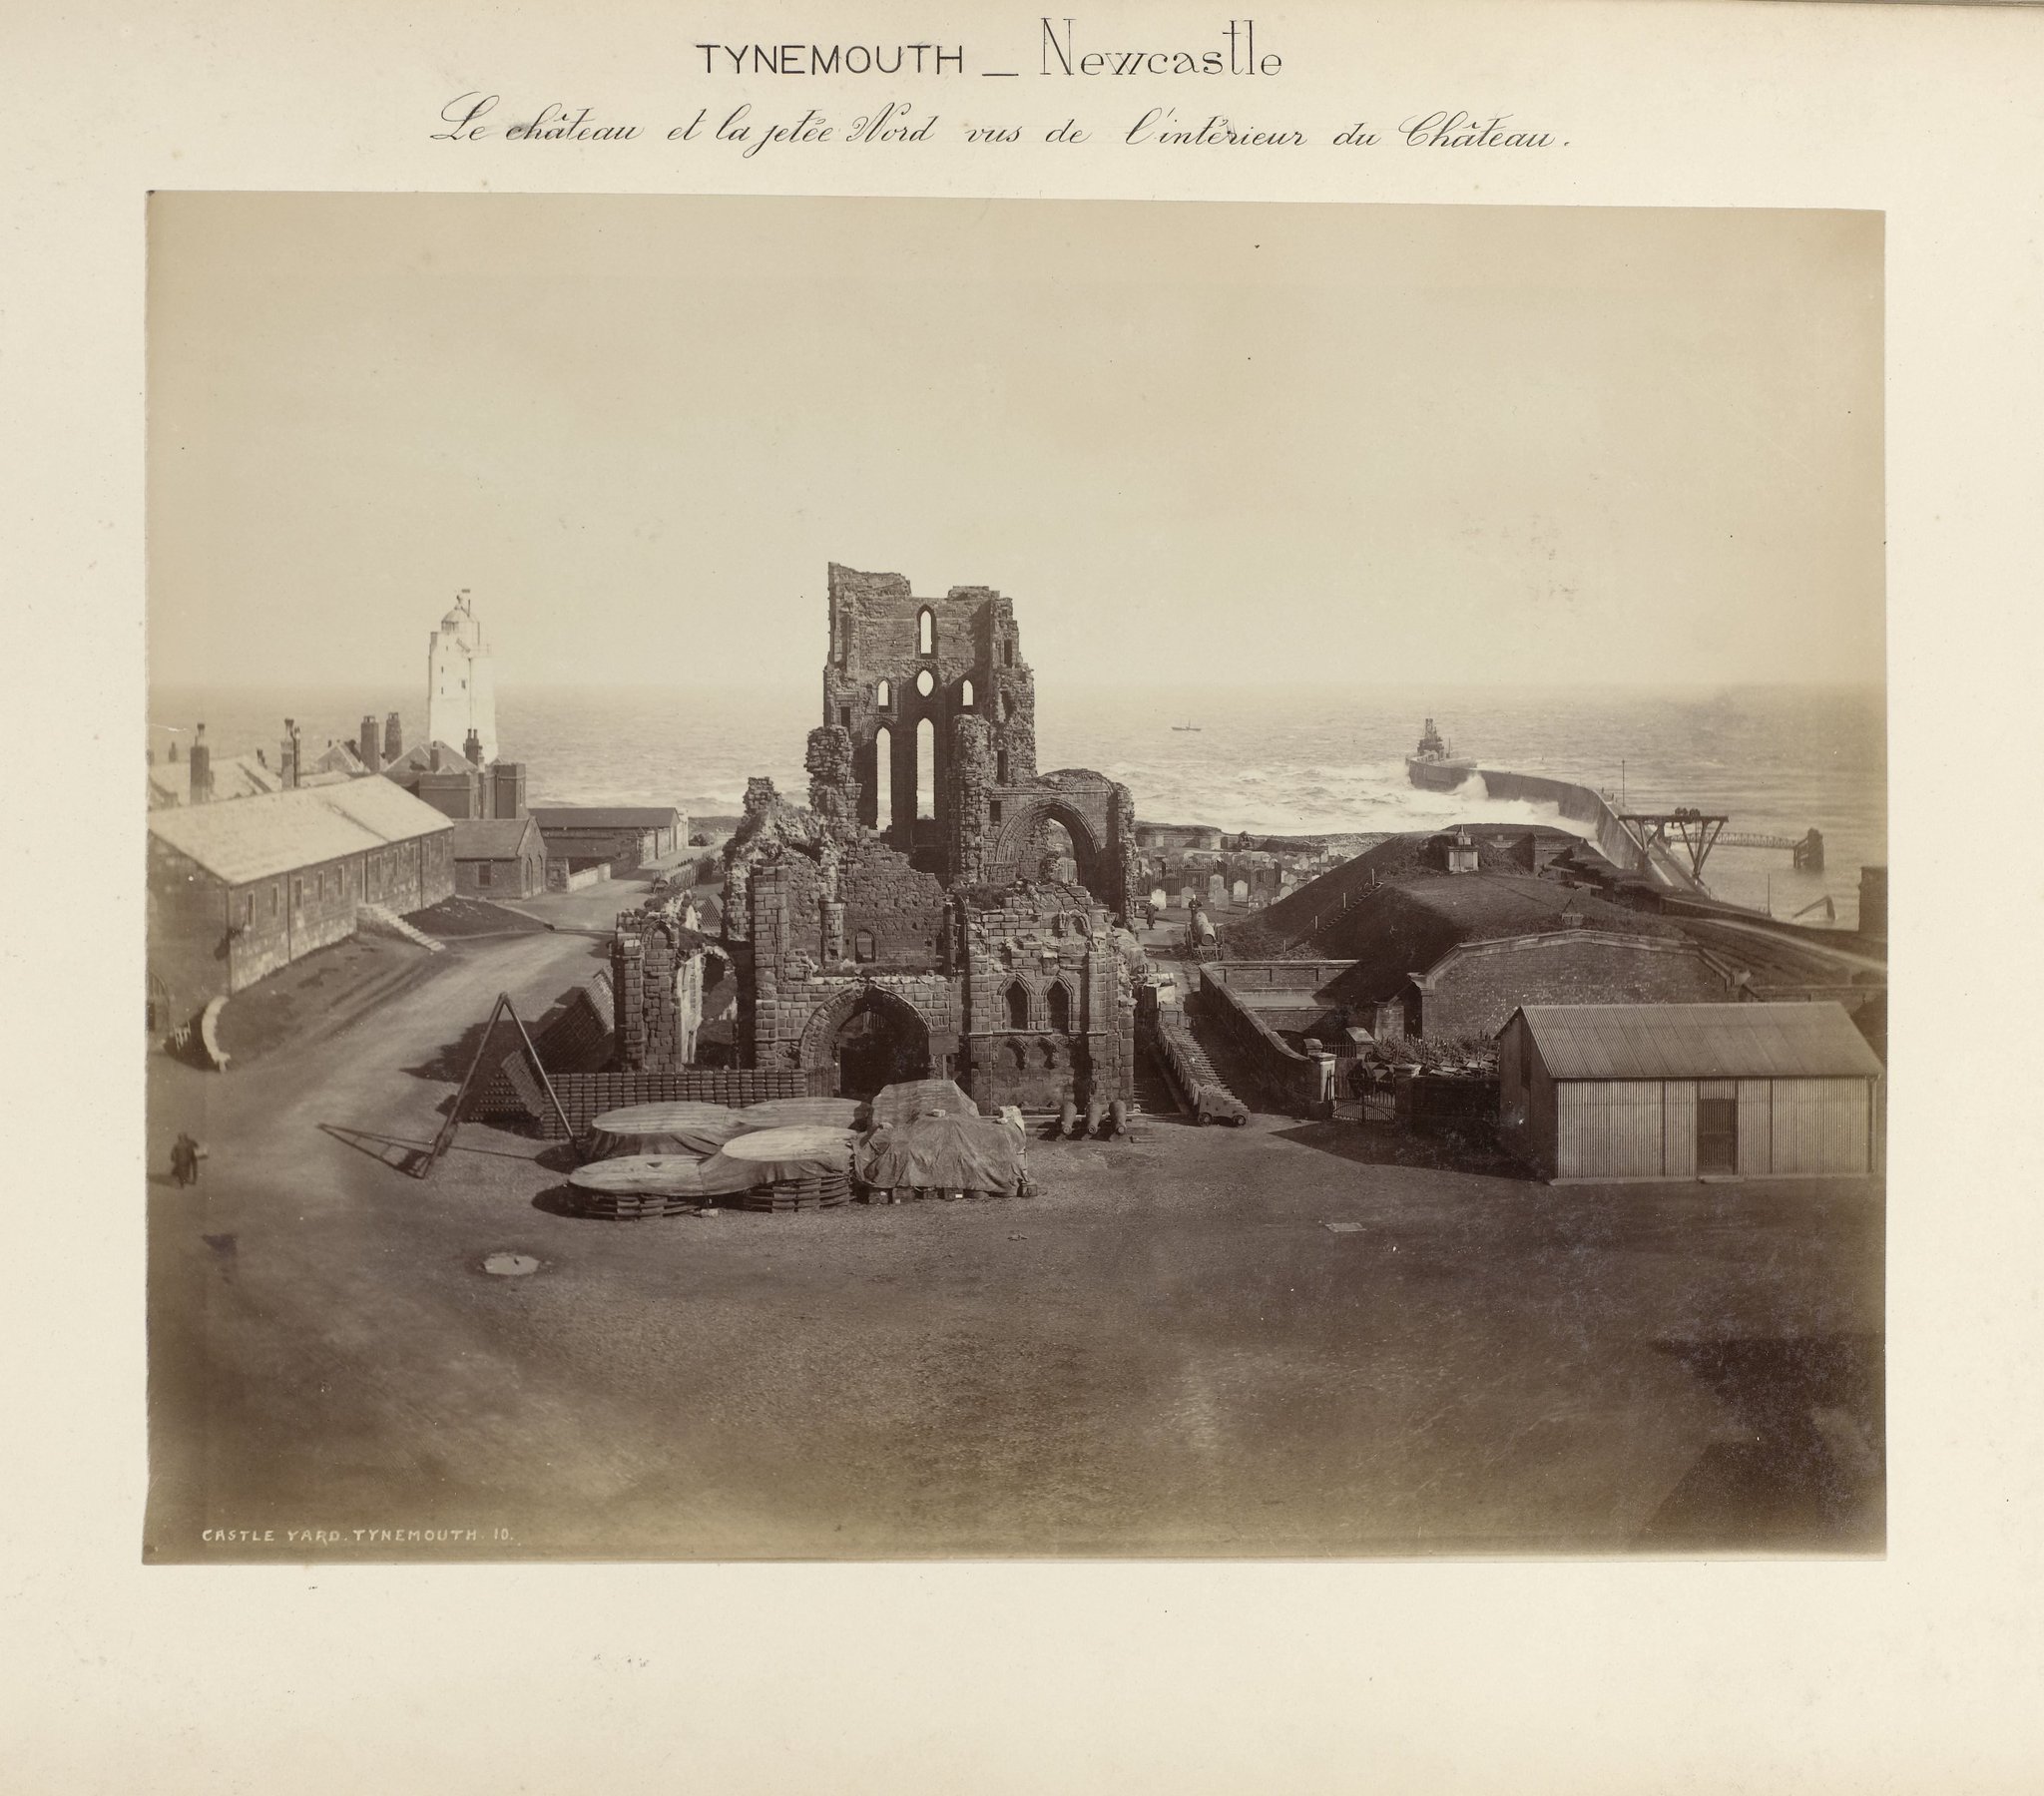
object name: photograph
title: Gezicht op het kasteel van Tynemouth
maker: Anonymous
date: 1891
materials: cardboard, paper, photographic support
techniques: albumen print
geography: great britain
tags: tynemouth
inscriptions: inscription: ‘TYNEMOUTH - Newcastle / Le château et la jetée Nord vus de l'intérieur du Château’, inscription: ‘CASTLE YARD. TYNEMOUTH 10’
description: Foto uit een album met 35 topografische foto's van Britse kustplaatsen, waarop in pen militaire verdedigingswerken zijn aangegeven door een Franse militair.